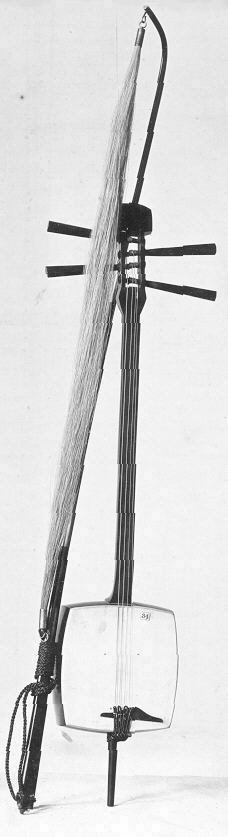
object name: kokyu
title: Kokyū (胡弓)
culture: japanese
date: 1801-1900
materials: wood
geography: japan